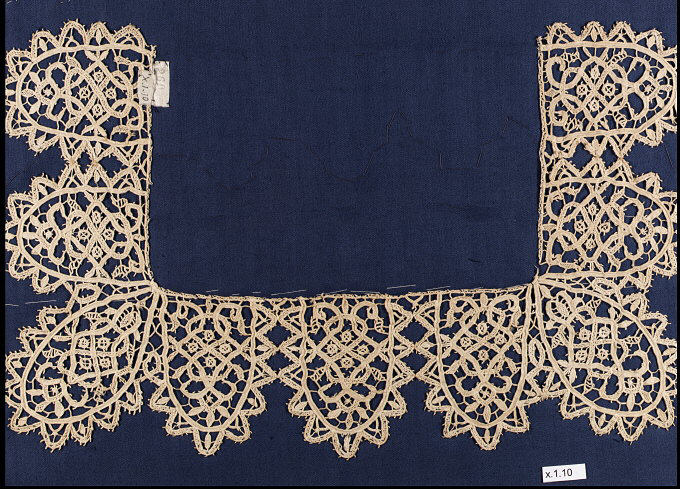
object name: collar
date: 1601-1633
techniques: lace